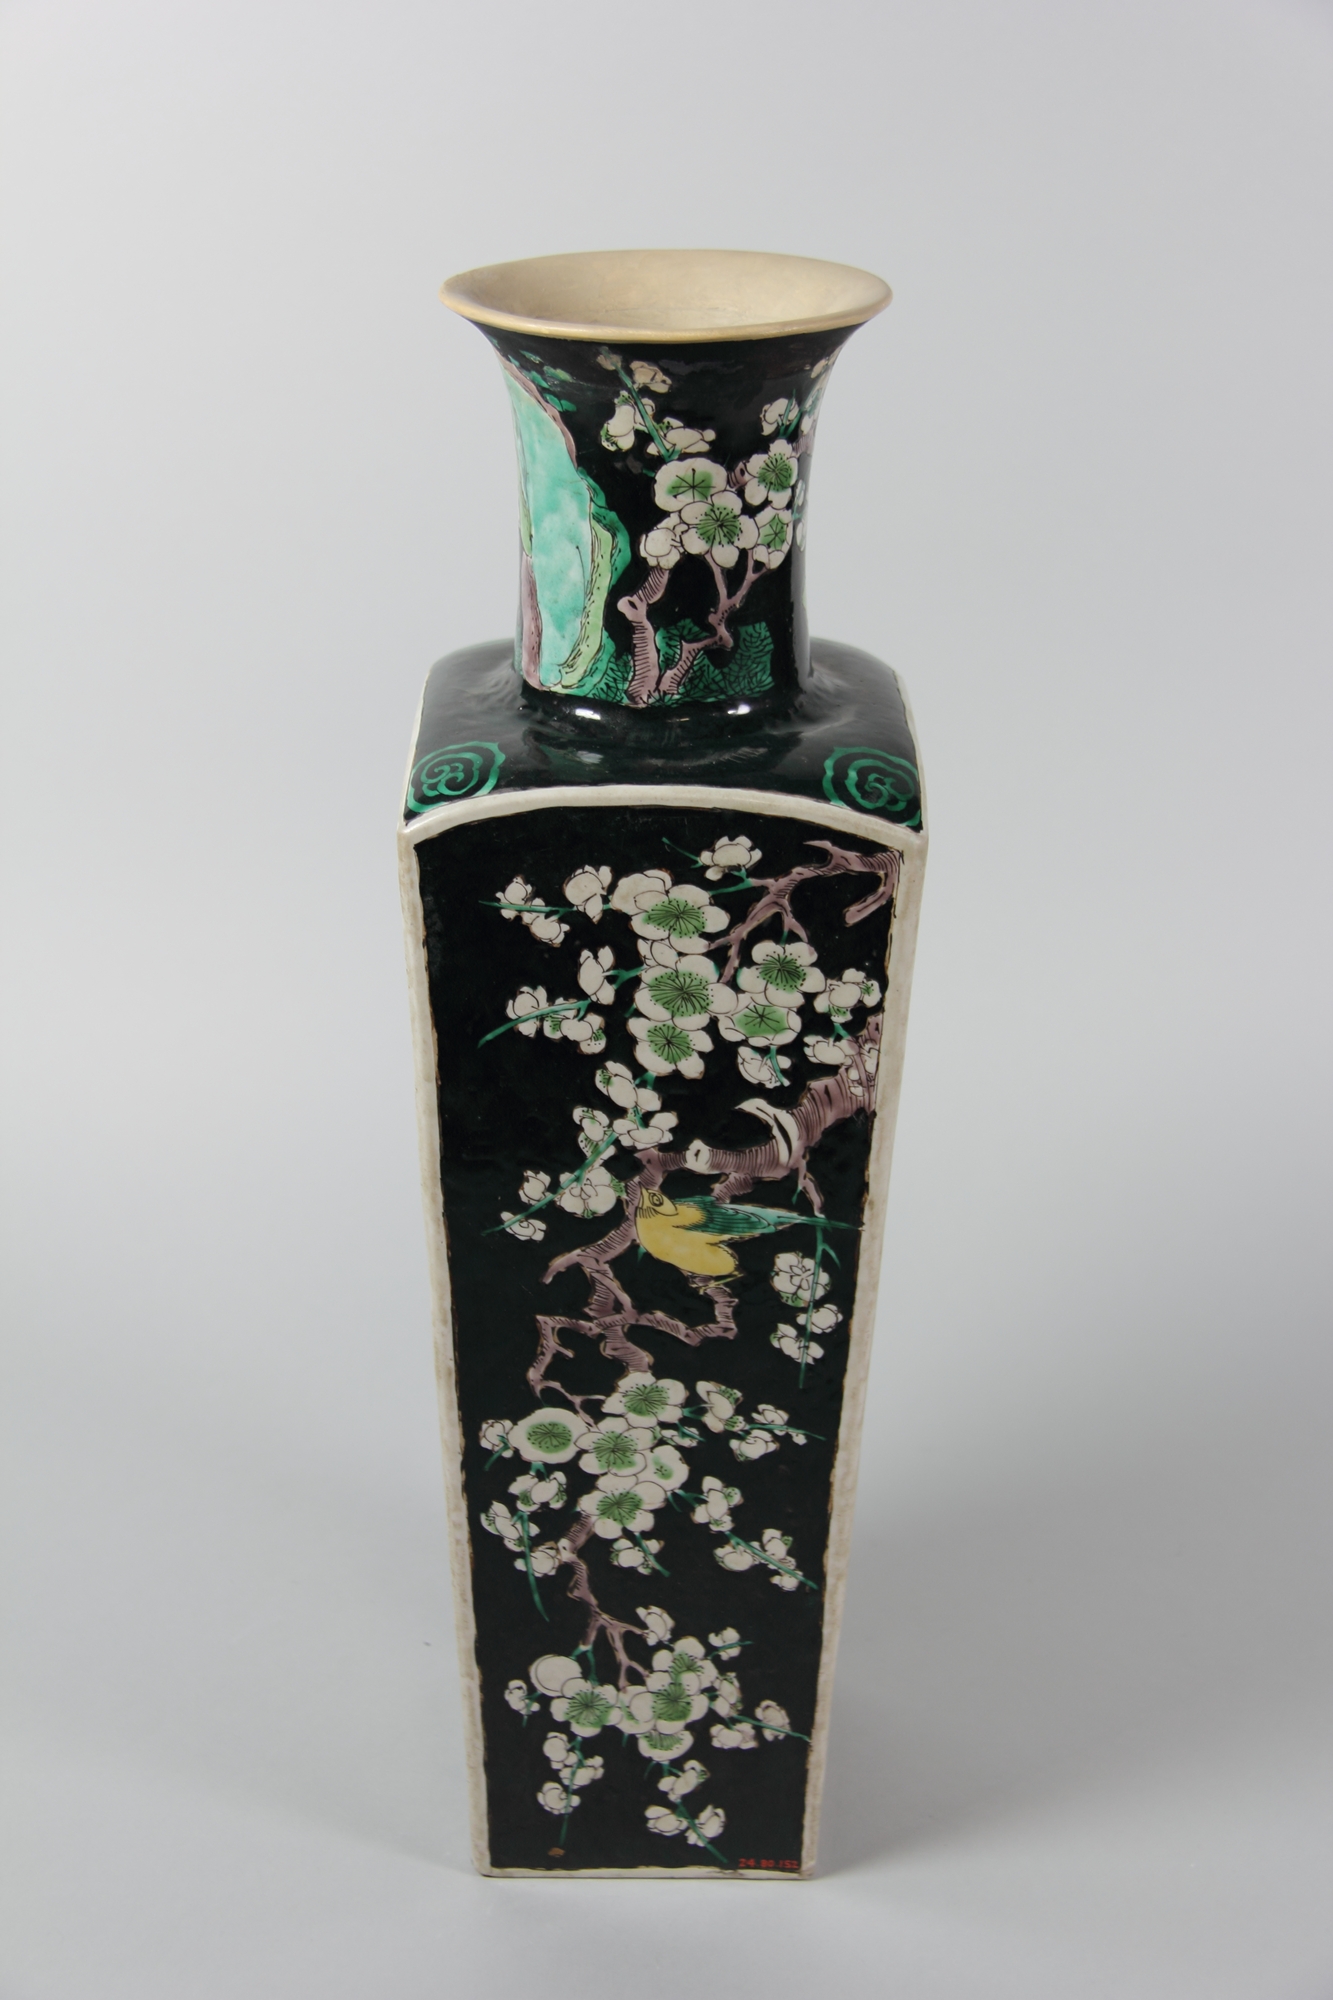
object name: vase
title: Square vase with birds and flowers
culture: chinese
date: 1801-1900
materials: enamel, porcelain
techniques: painting, polychrome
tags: birds,flowers